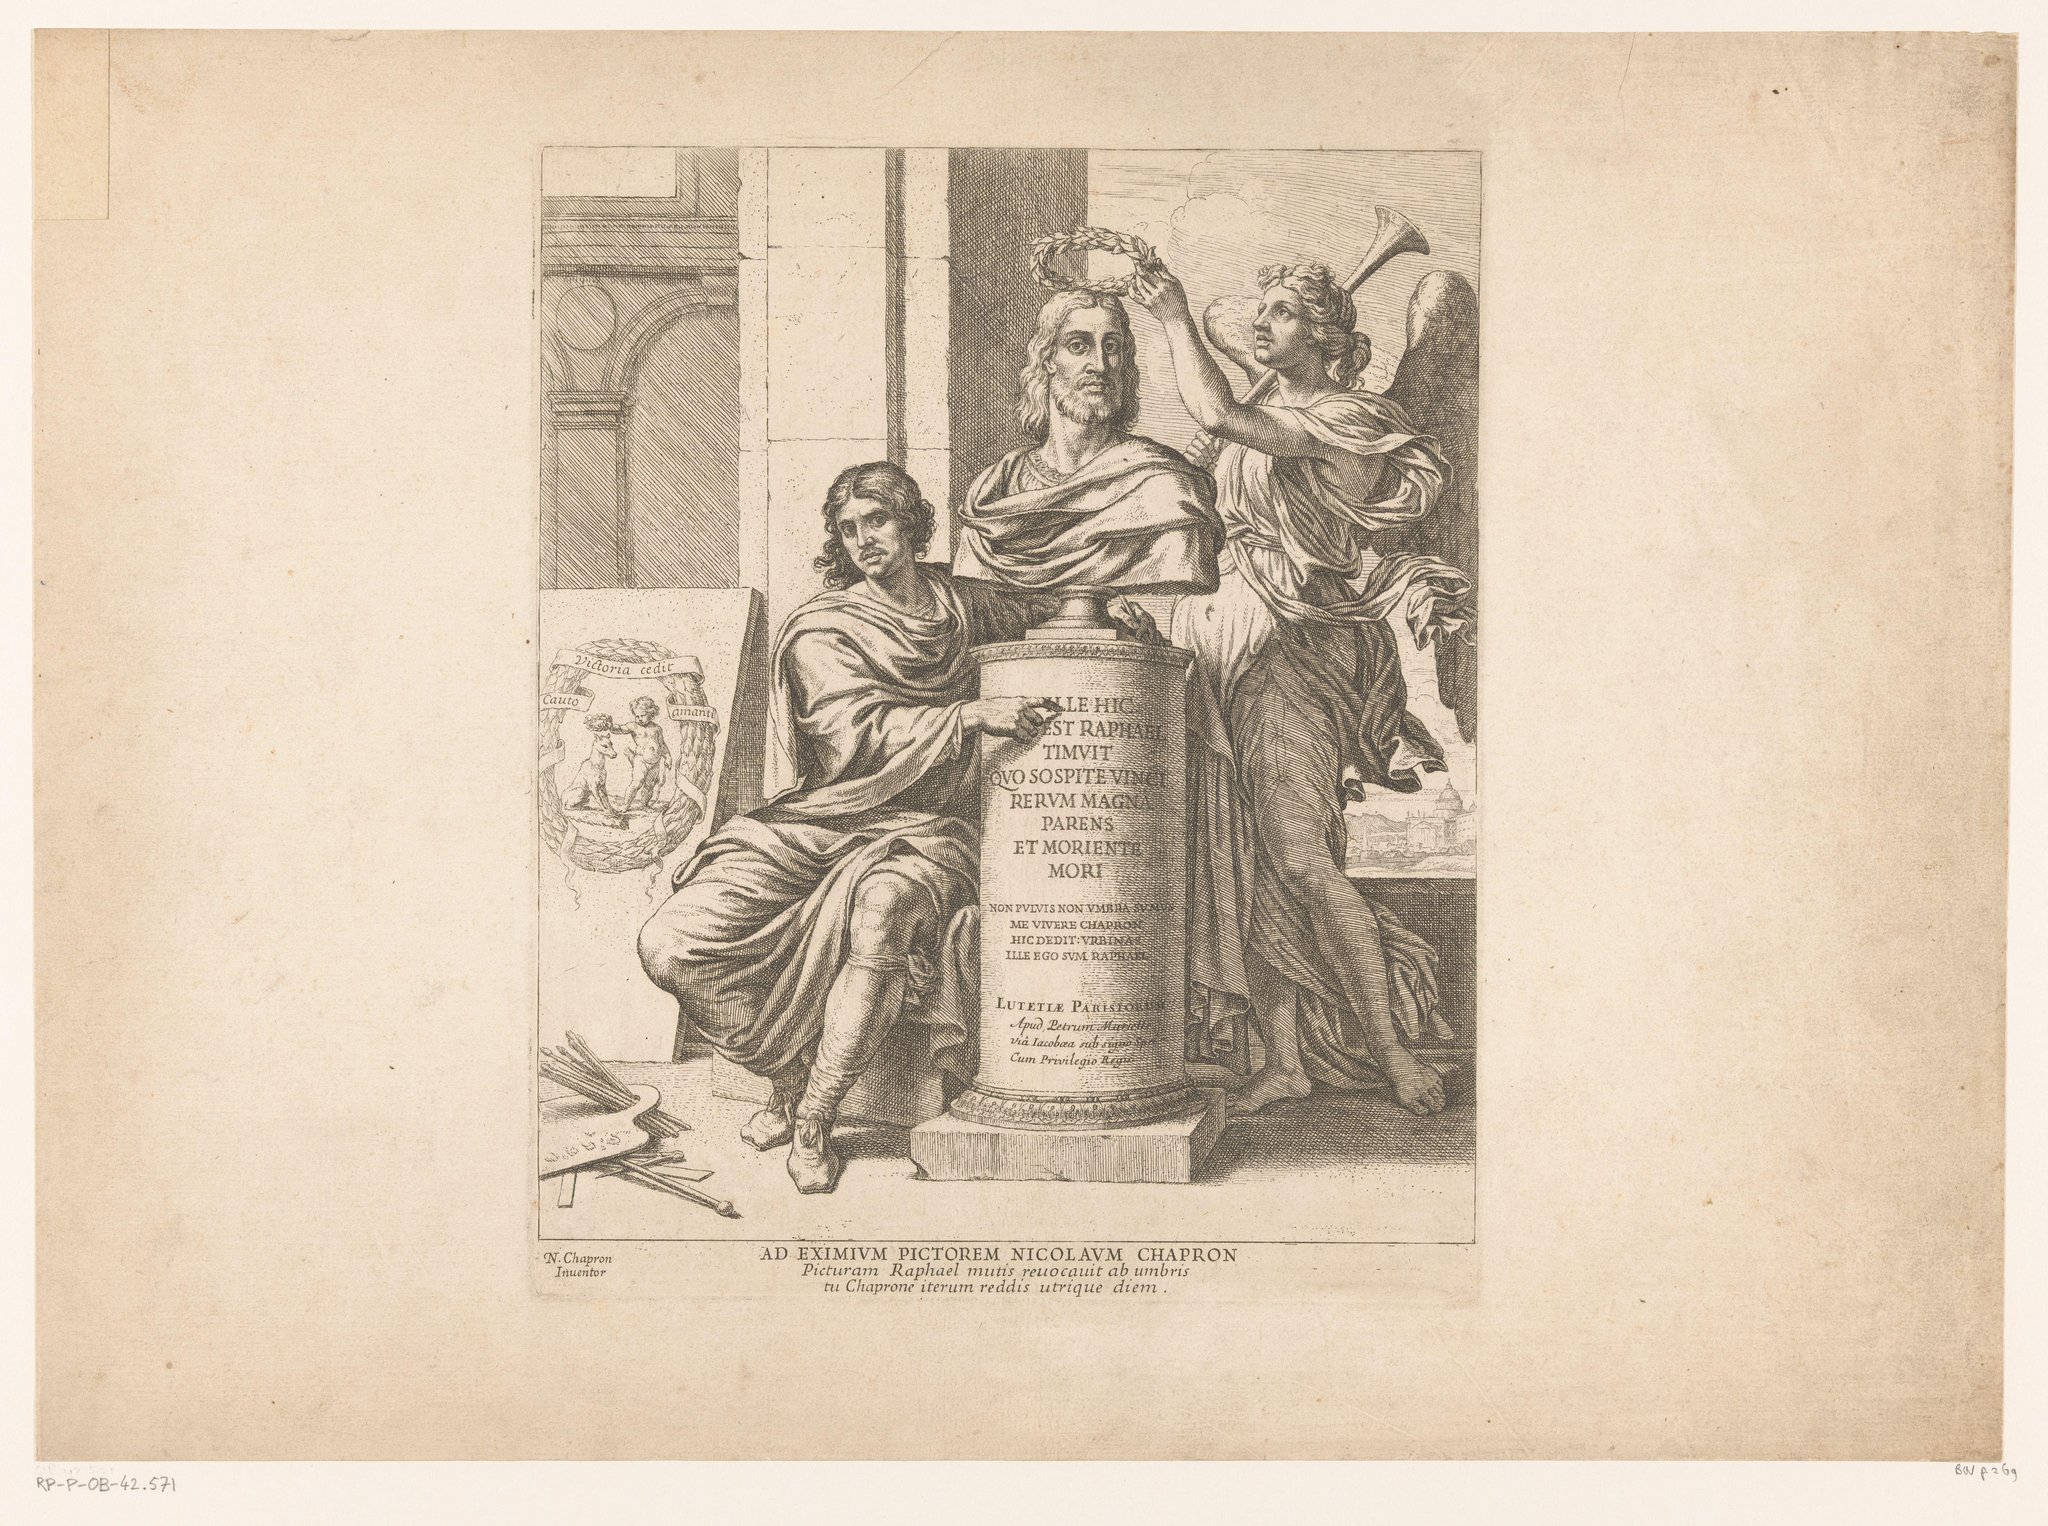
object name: print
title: Sacrae Historiae Acta a Raphael Urbin in Vaticanis xystis ad picturae miraculum expressa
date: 1649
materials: paper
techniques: etching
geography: paris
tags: rome, rafaël, lyon, painter, print maker, nicolas chaperon, fama as roman personification, portrait, self-portrait of artist, crowning with laurel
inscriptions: collector's mark: Lugt 2228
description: Betreft de titelprent voor Sacrae Historiae Acta a Raphael Urbin in Vaticanis xystis ad picturae miraculum expressa, ook bekend als de Rafaël Bijbel. De serie bestaat uit 54 platen, waarvan twee titelprenten, de eerste met een opdracht aan Rafaël, de tweede met een opdracht aan Renard. De overige 52 platen betreffen composities naar schilderingen in de Loggia van Rafaël in het Vaticaan door Rafaël. De serie werd in 1649 uitgegeven door Pierre Mariette te Parijs.